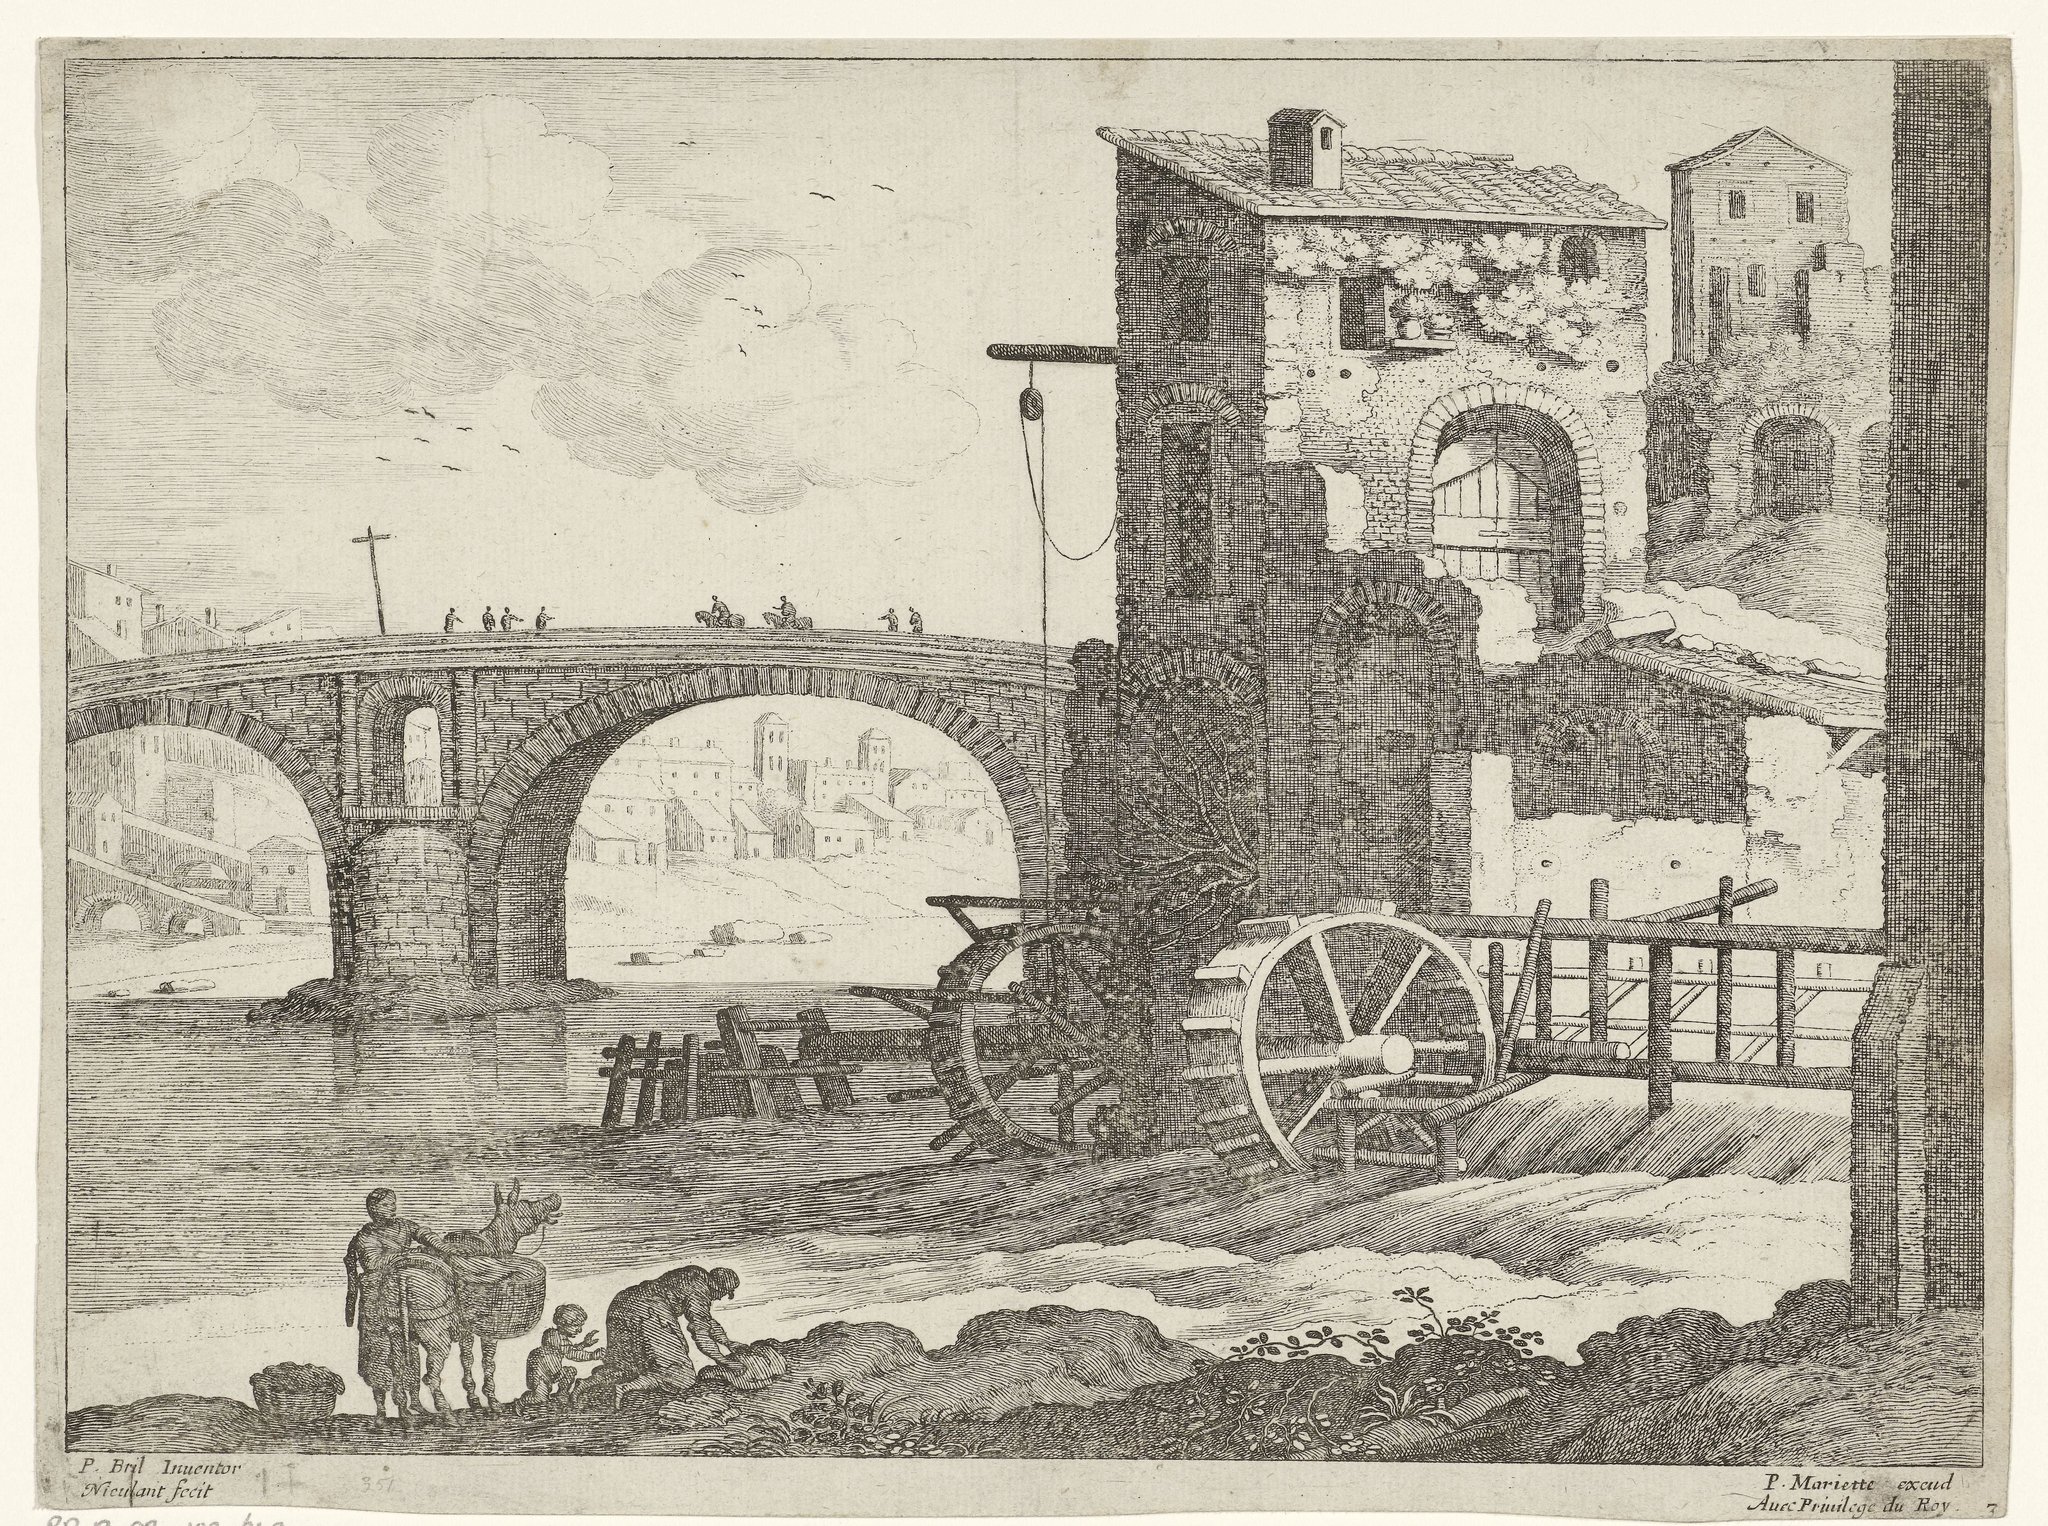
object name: print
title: Brug en watermolen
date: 1594-1635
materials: paper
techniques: engraving, etching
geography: paris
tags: laundering, watermill, bridge in city across river, canal, etc.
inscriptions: collector's mark: Lugt 2228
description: Een stenen brug over een rivier en rechts een watermolen. Op de voorgrond staat een vrouw bij een bepakte ezel. Daarnaast een vrouw, die op haar knieën de was doet. Prent uit een serie Italiaanse landschappen.